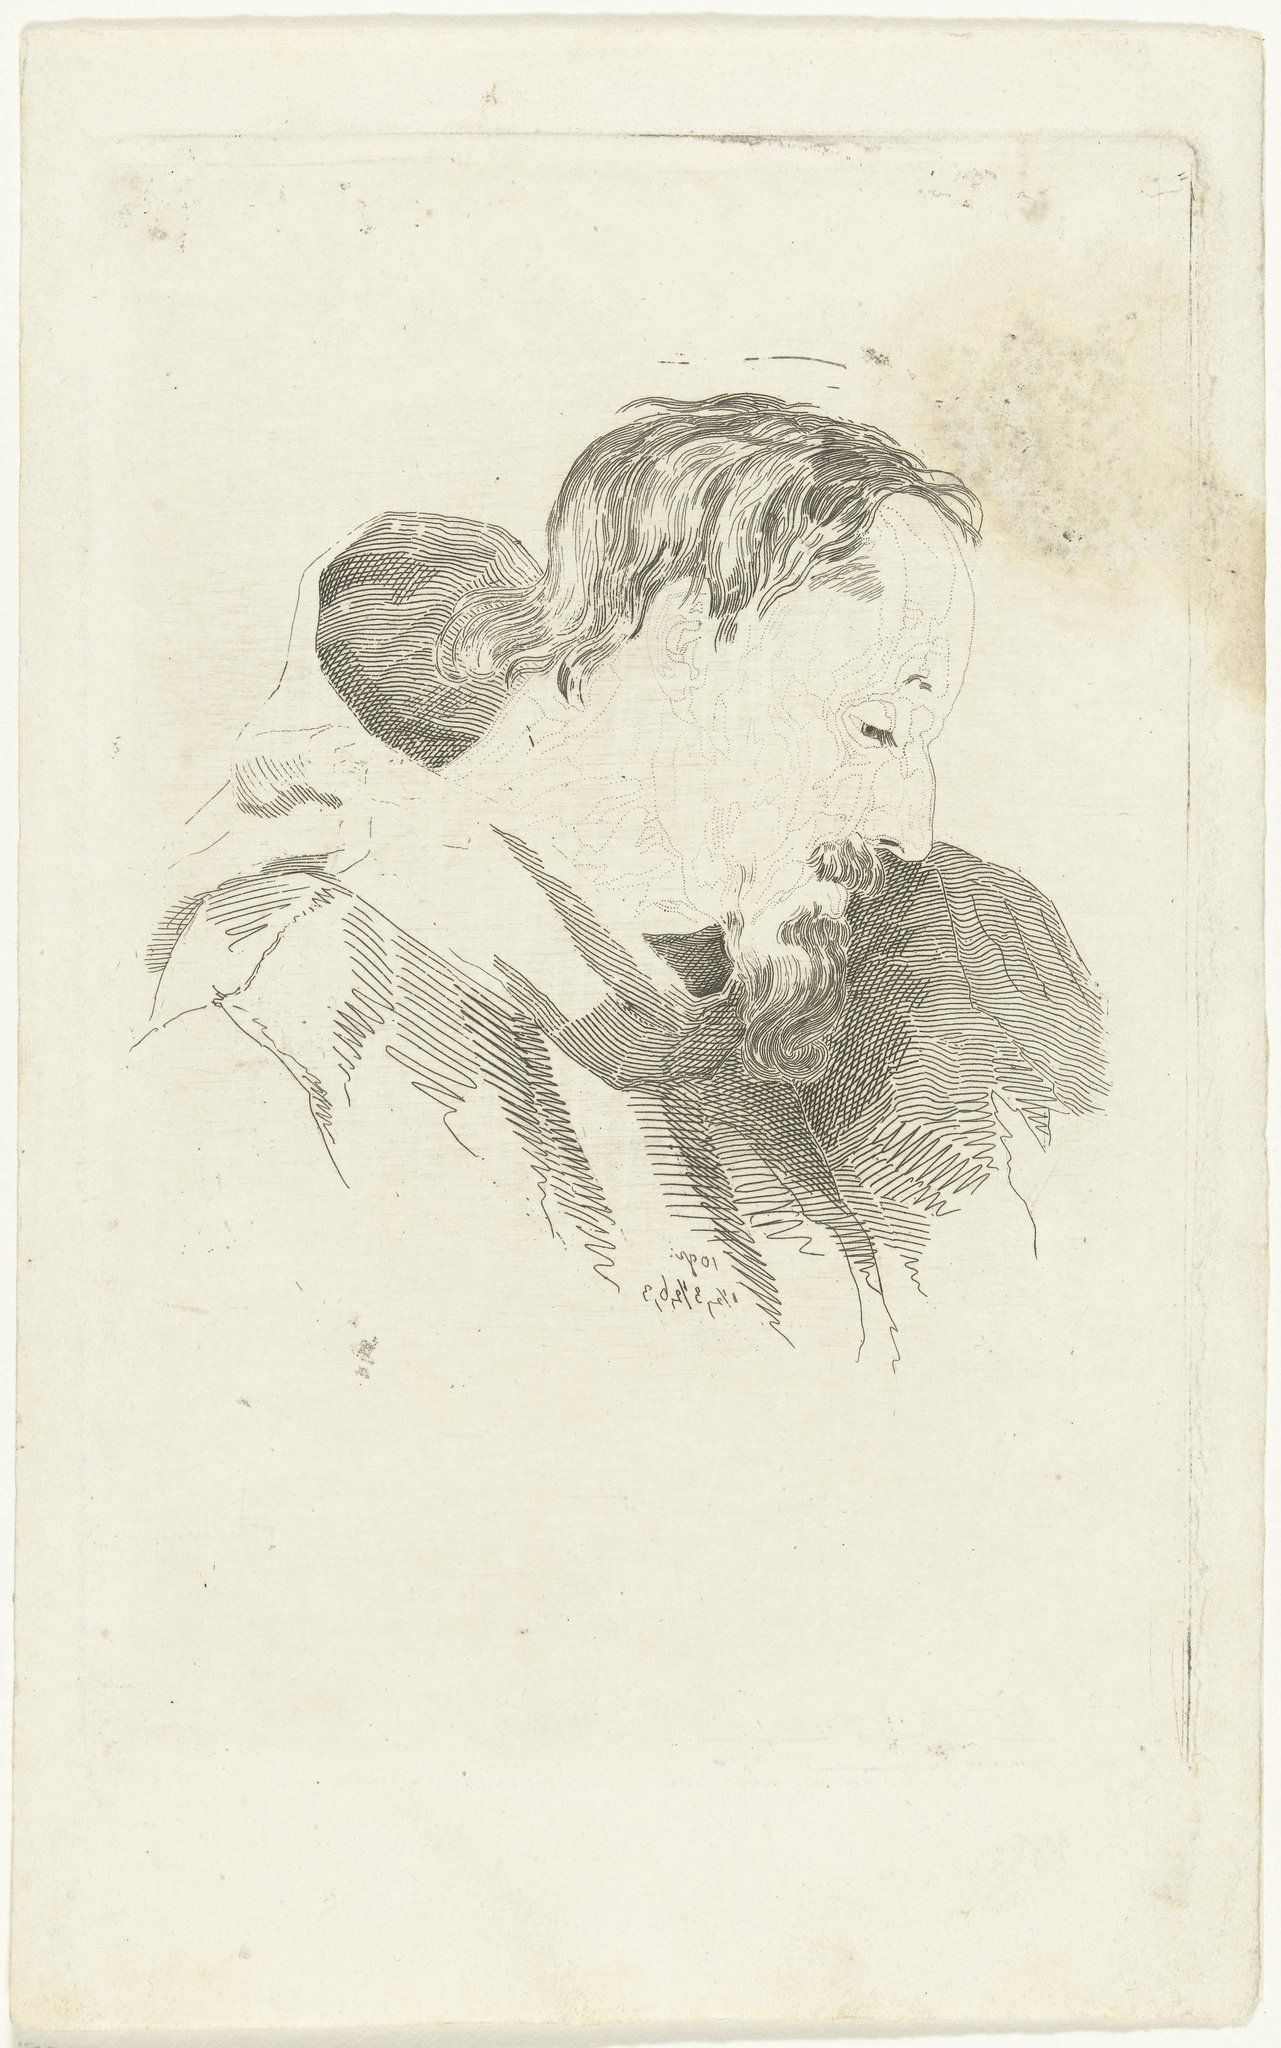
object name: print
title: Portretbuste van een monnik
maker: henricus wilhelmus couwenberg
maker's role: draughtsman, print maker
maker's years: 1814-1845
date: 1830-1845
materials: paper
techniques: etching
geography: amsterdam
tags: monk(s), friar(s)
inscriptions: collector's mark: Lugt 2228